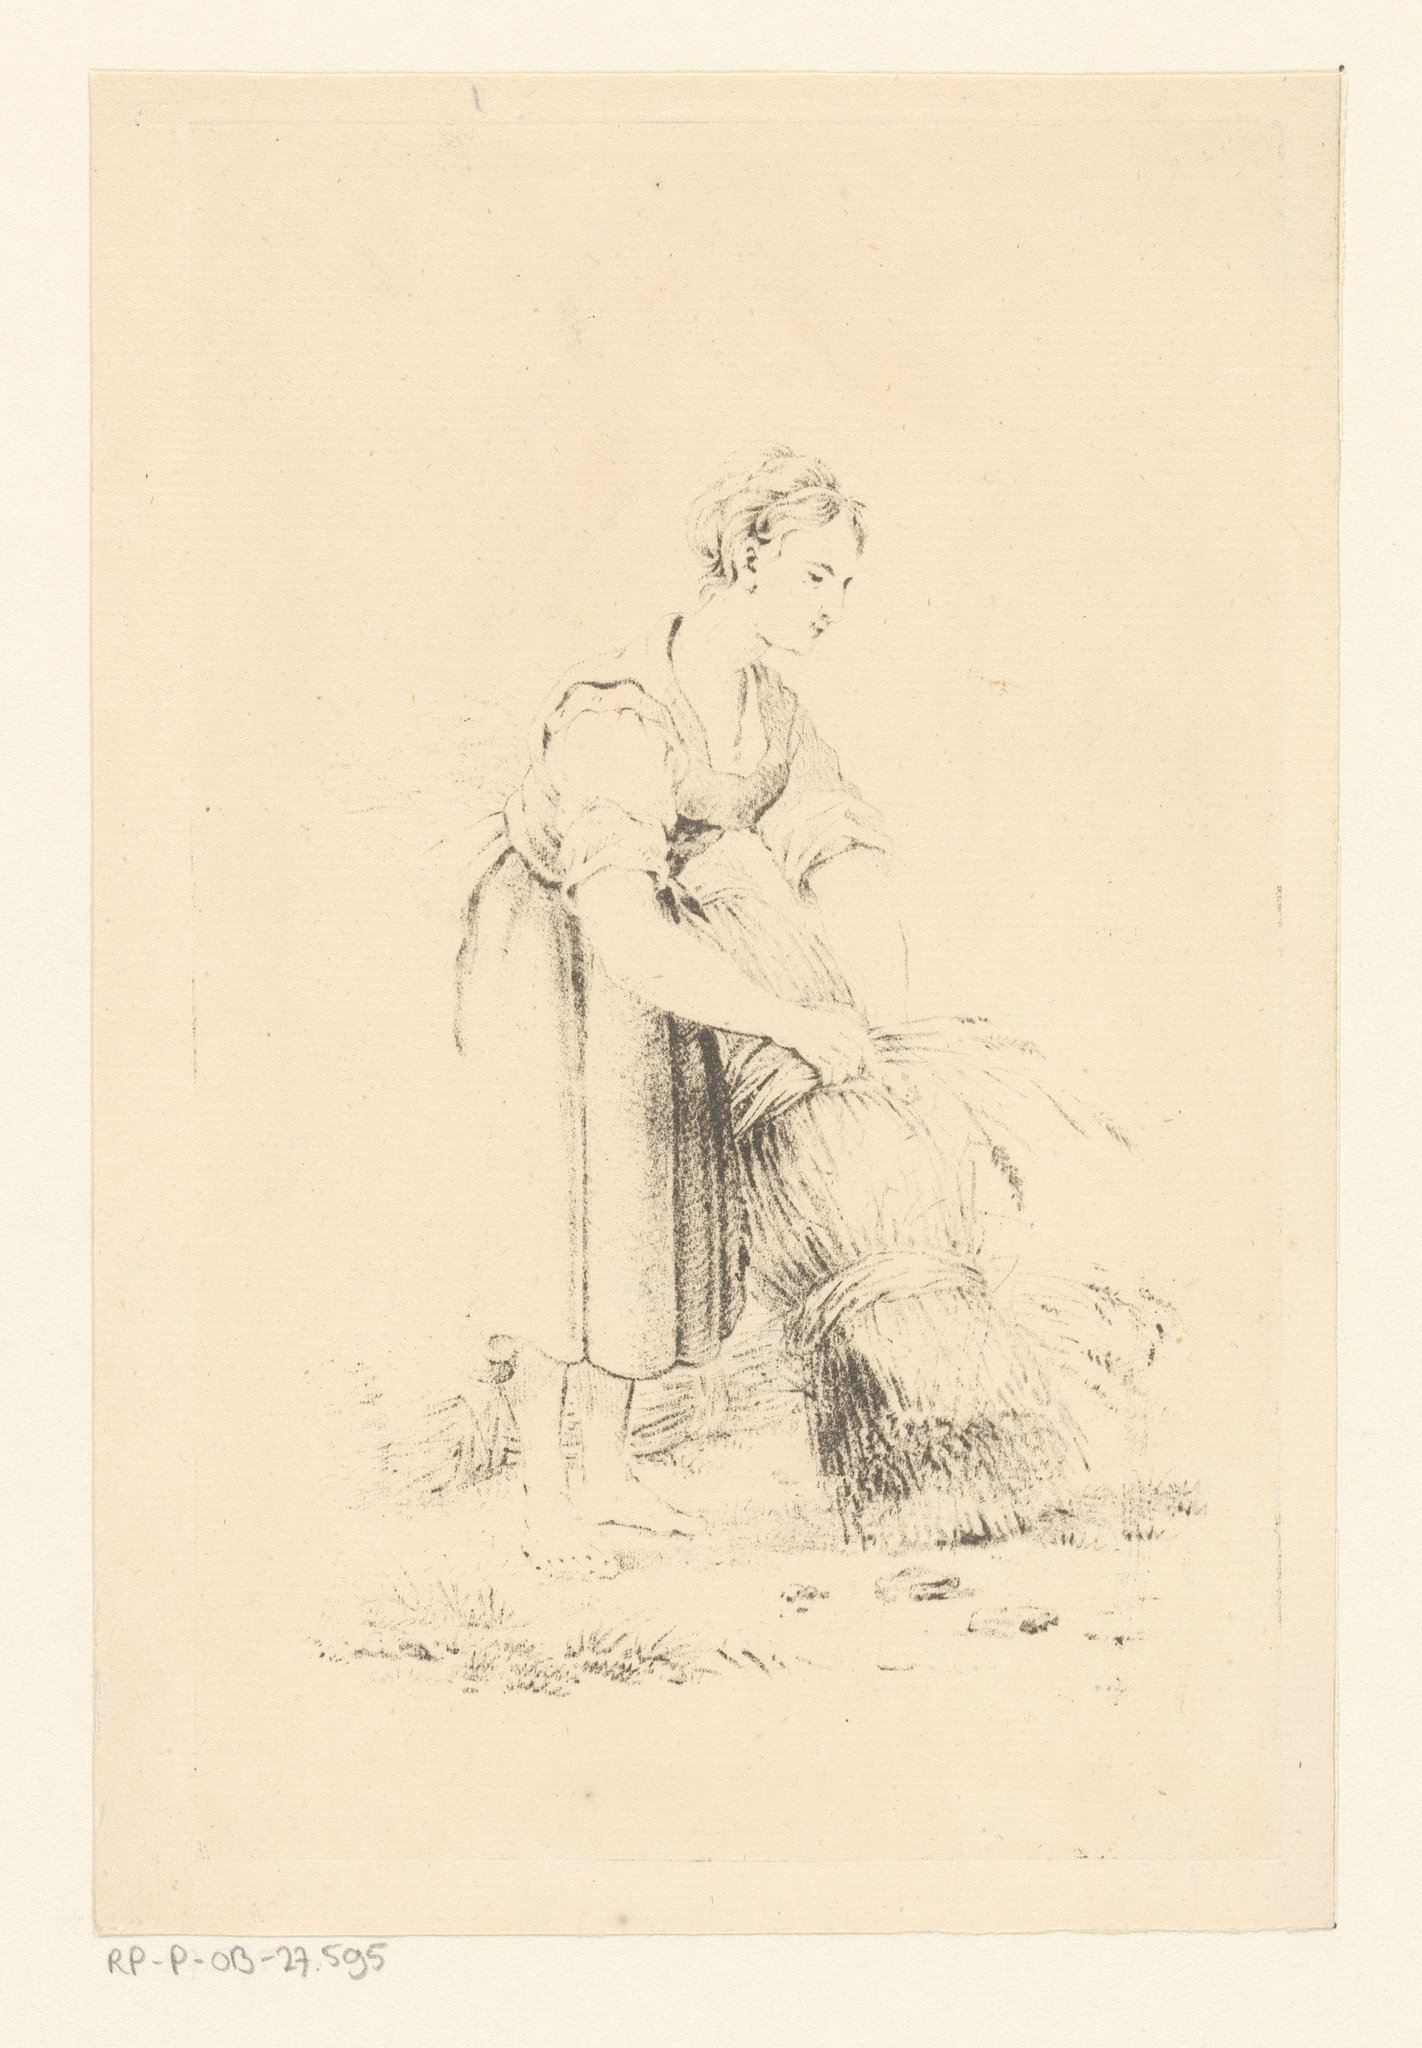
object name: print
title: Vrouw met een korenschoof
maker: pieter bartholomeusz. barbiers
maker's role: draughtsman, print maker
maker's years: 1772-1837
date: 1809-1837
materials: paper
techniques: lithograph, lithography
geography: haarlem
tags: plants and herbs: wheat, binding ~ harvest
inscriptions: collector's mark: Lugt 2228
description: De vrouw staat licht voorover gebogen en bindt een bundel koren tot een korenschoof. Achter haar op de grond ligt een voltooide schoof.